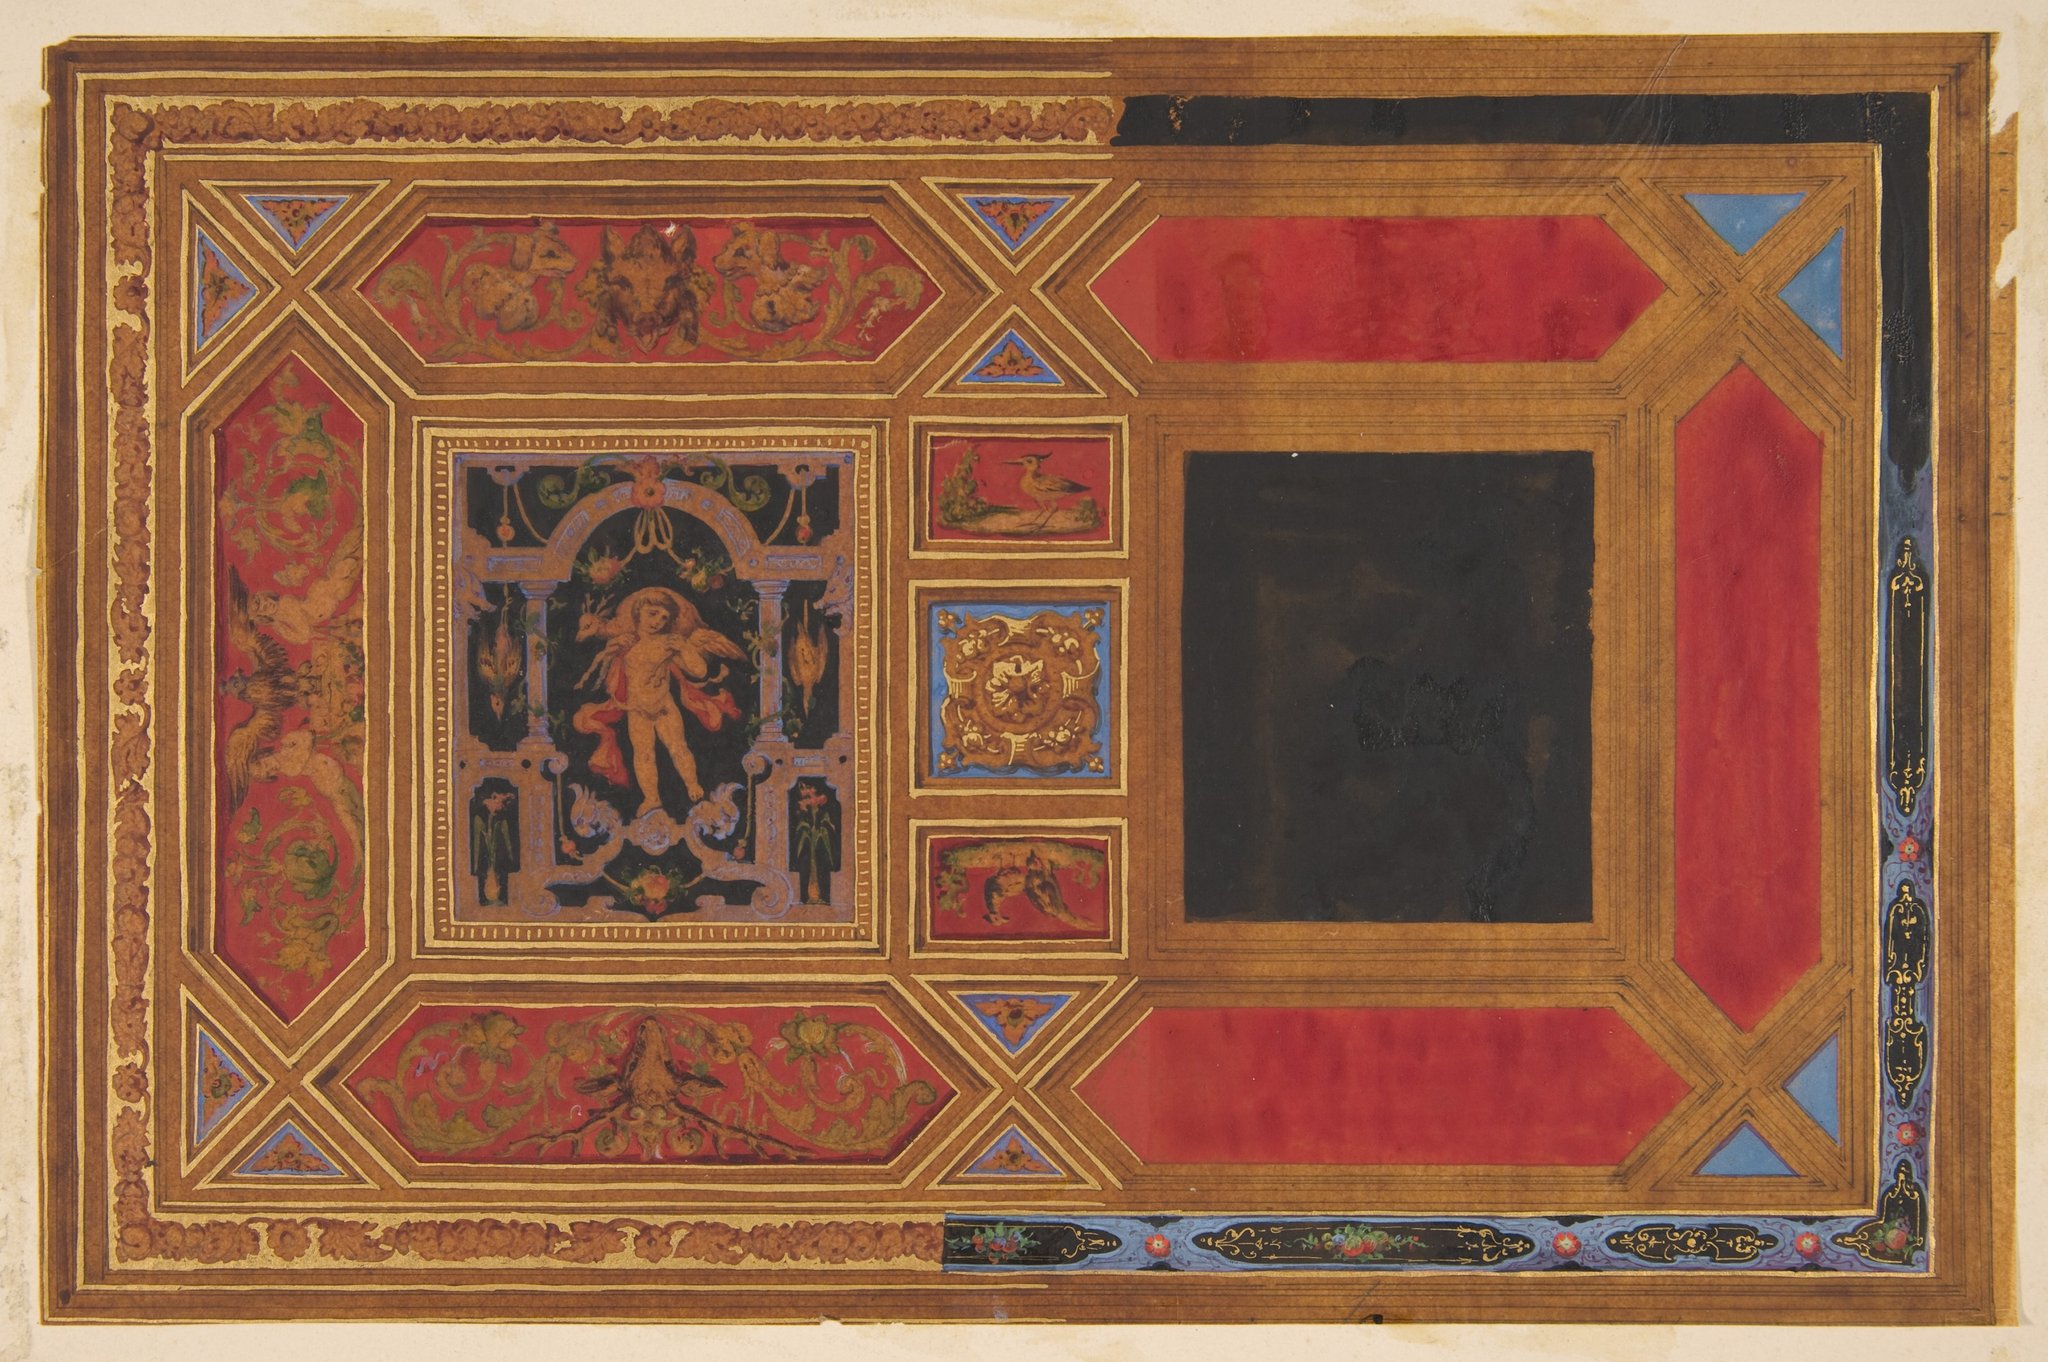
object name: drawing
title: Design for a ceiling painted with grotesque motifs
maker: jules-edmond-charles lachaise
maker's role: artist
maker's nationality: french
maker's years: 1897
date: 1801-1900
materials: gold paint, graphite, ink, paper, watercolor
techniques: pen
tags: birds,grotesques,ornament,putti